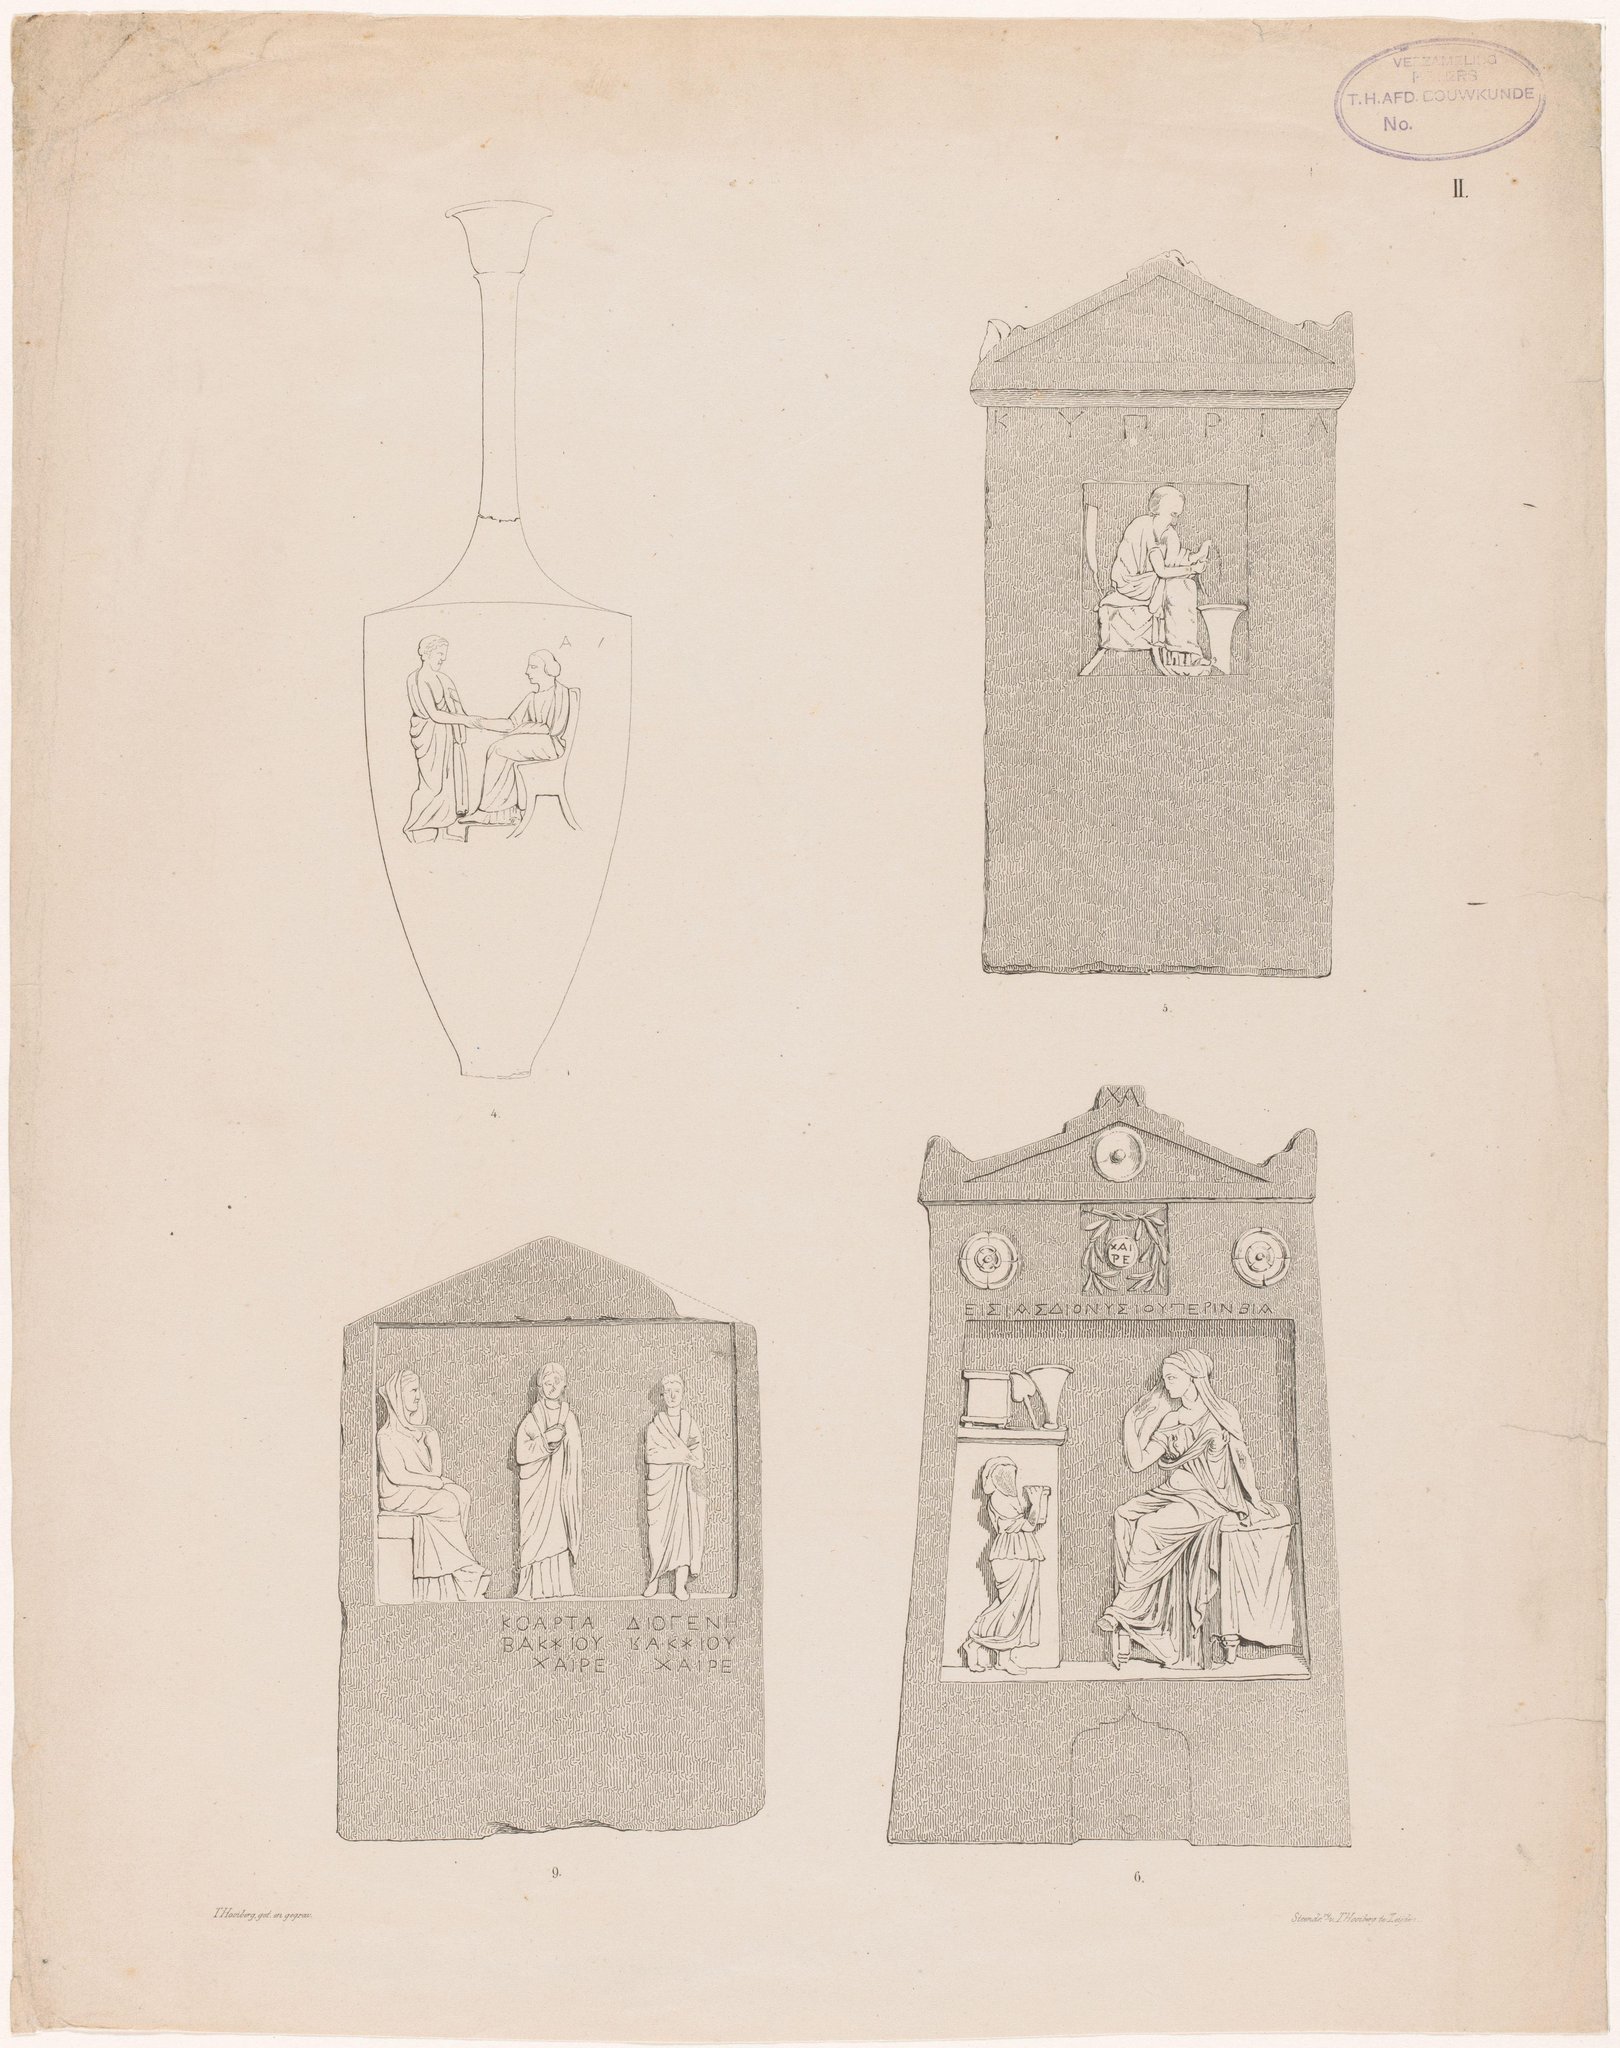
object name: print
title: Griekse vaas en grafstenen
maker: tiemen hooiberg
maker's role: painter, print maker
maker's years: 1809-1897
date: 1819-1897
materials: paper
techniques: lithograph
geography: netherlands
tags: vase ~ ornament, gravestone, tombstone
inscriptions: collector's mark: ‘Verzameling [...]rs T.H. Afd. Bouwkunde No.’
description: Reproductie van Griekse vaas en drie grafstenen met menselijke figuren en Grieks opschrift. Genummerd 4, 5, 6 en 9. Rechts boven II genummerd.